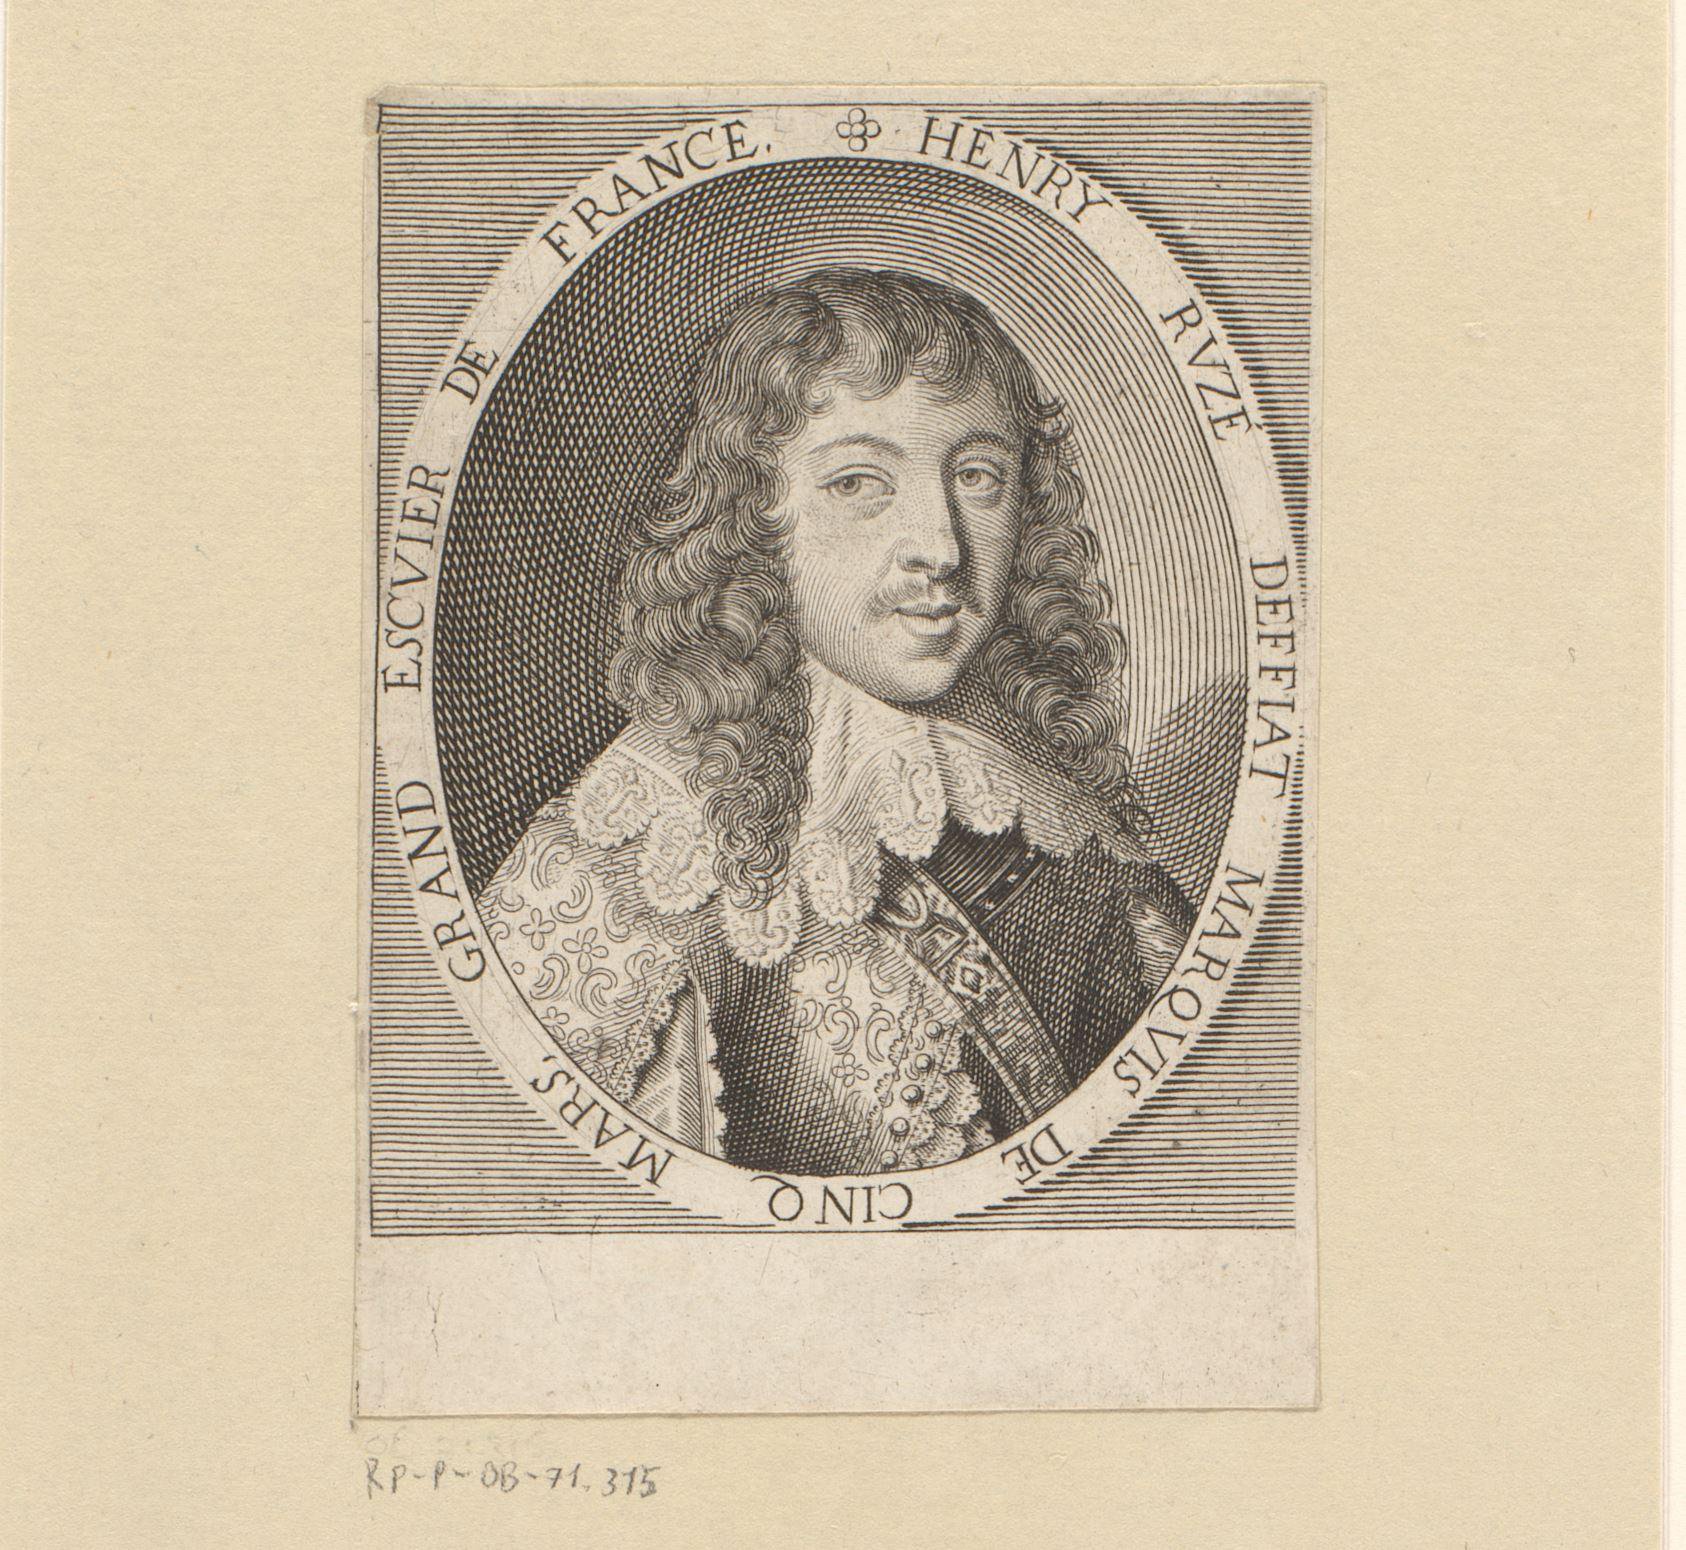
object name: print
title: Portret van Henri Coiffier de Ruzé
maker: claude mellan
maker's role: draughtsman, print maker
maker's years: 1598-1688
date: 1640-1688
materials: paper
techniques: engraving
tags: historical persons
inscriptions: collector's mark: Lugt 240